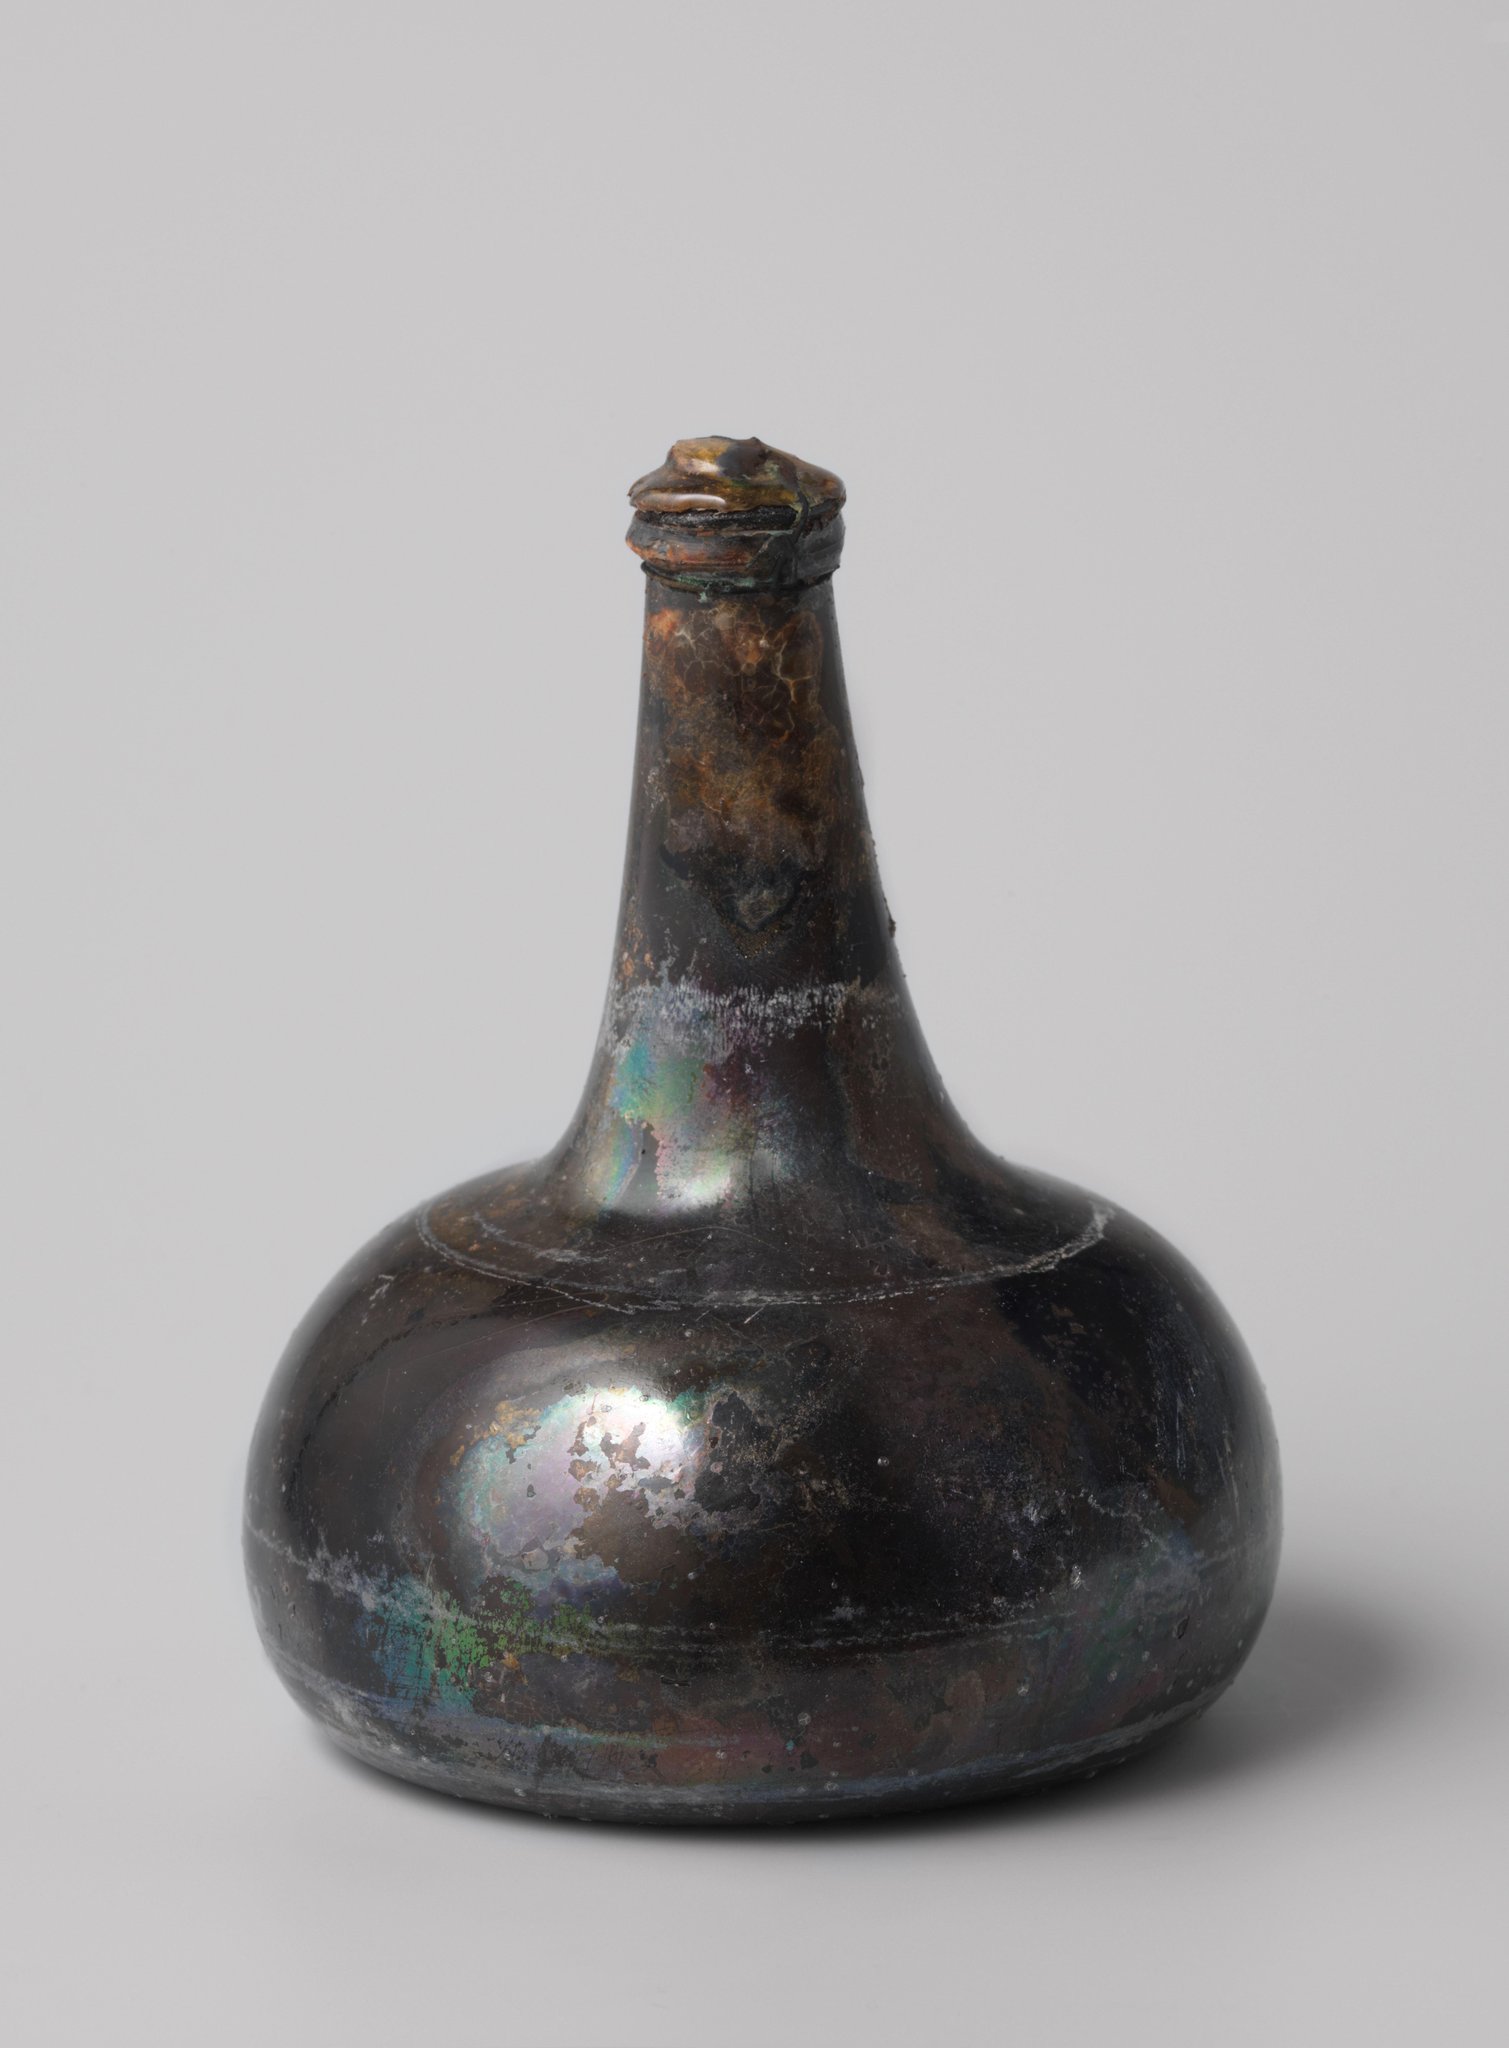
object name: wine bottle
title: Wijnfles met wijn uit het wrak van de Oost-Indiëvaarder 't Vliegend Hart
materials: glass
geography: netherlands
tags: 't vliegend hart (schip), verenigde oostindische compagnie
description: Uivormige wijnfles van groen glas gevuld met rode (port)wijn en afgesloten met kurk en draad.